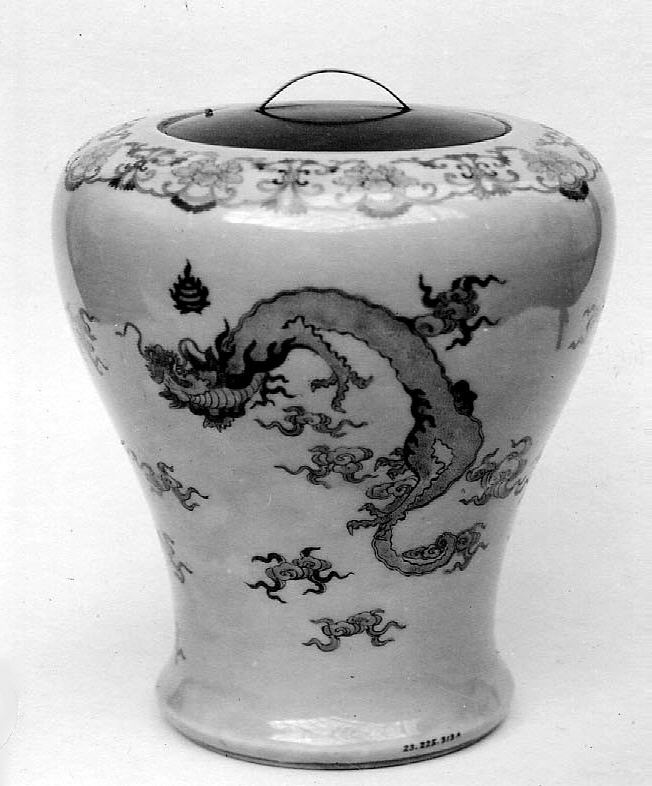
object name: jar with cover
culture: japanese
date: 1780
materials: ceramic glaze, enamel, glaze, porcelain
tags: dragons